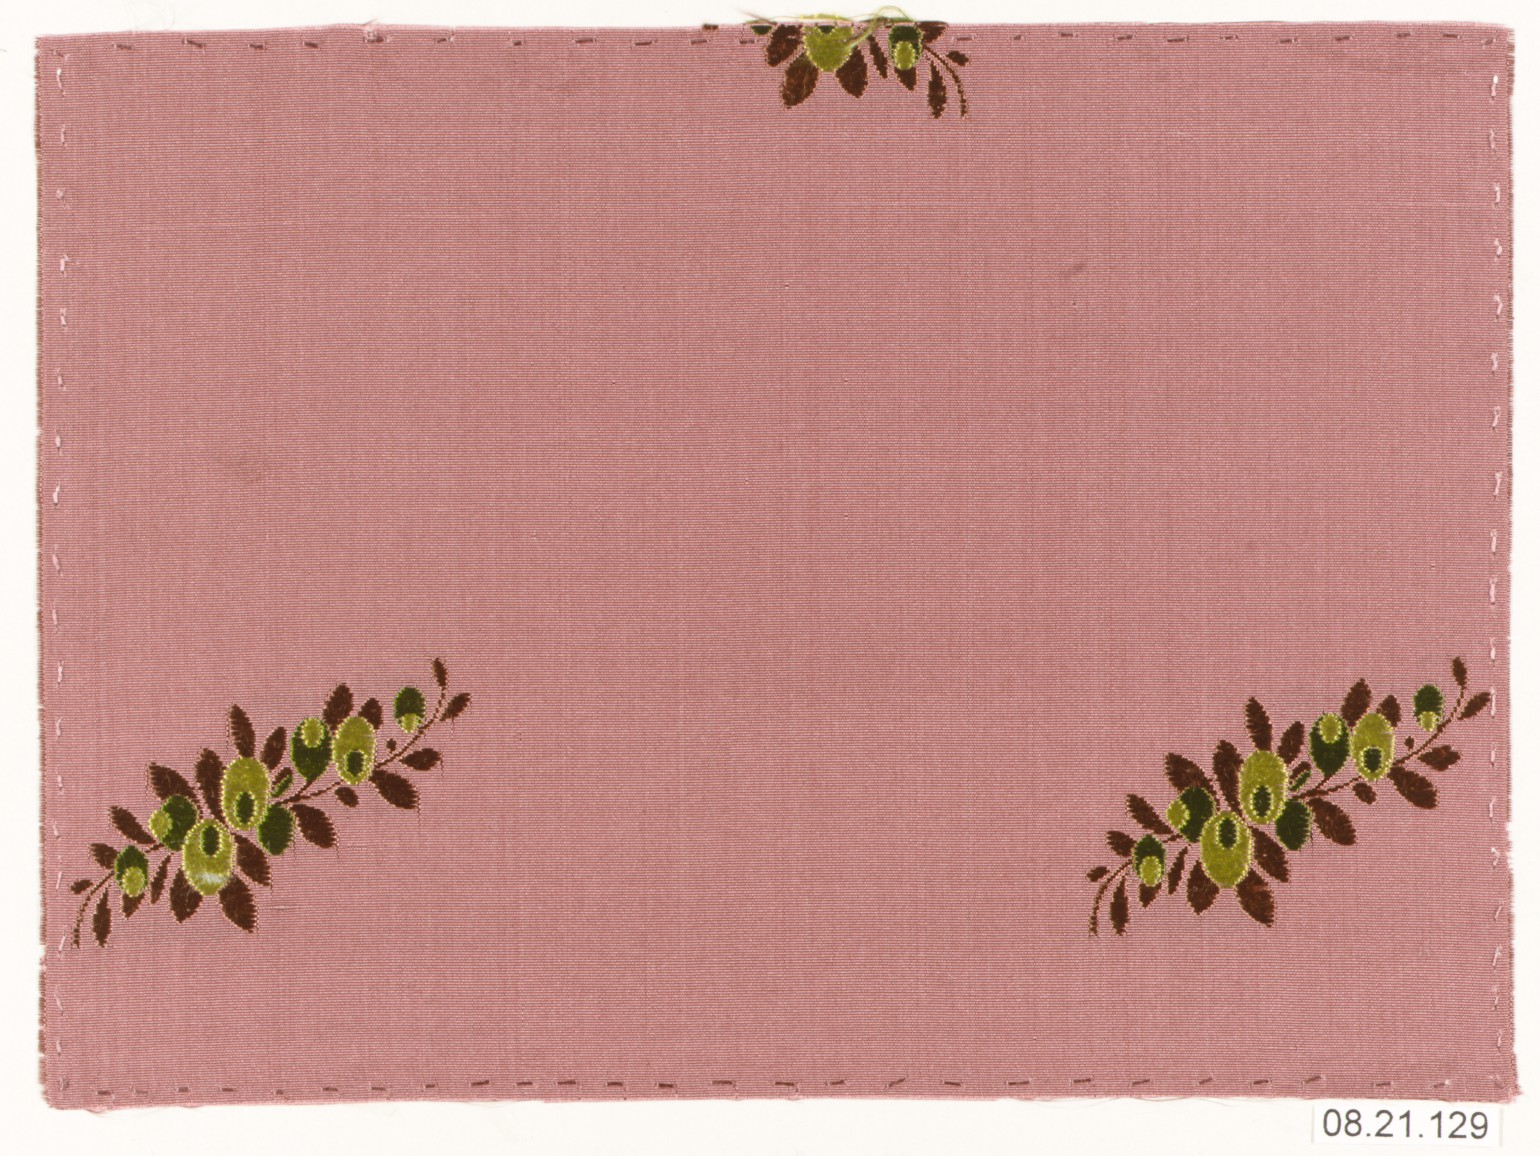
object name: textile sample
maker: Anonymous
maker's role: designer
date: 1900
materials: silk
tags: flowers